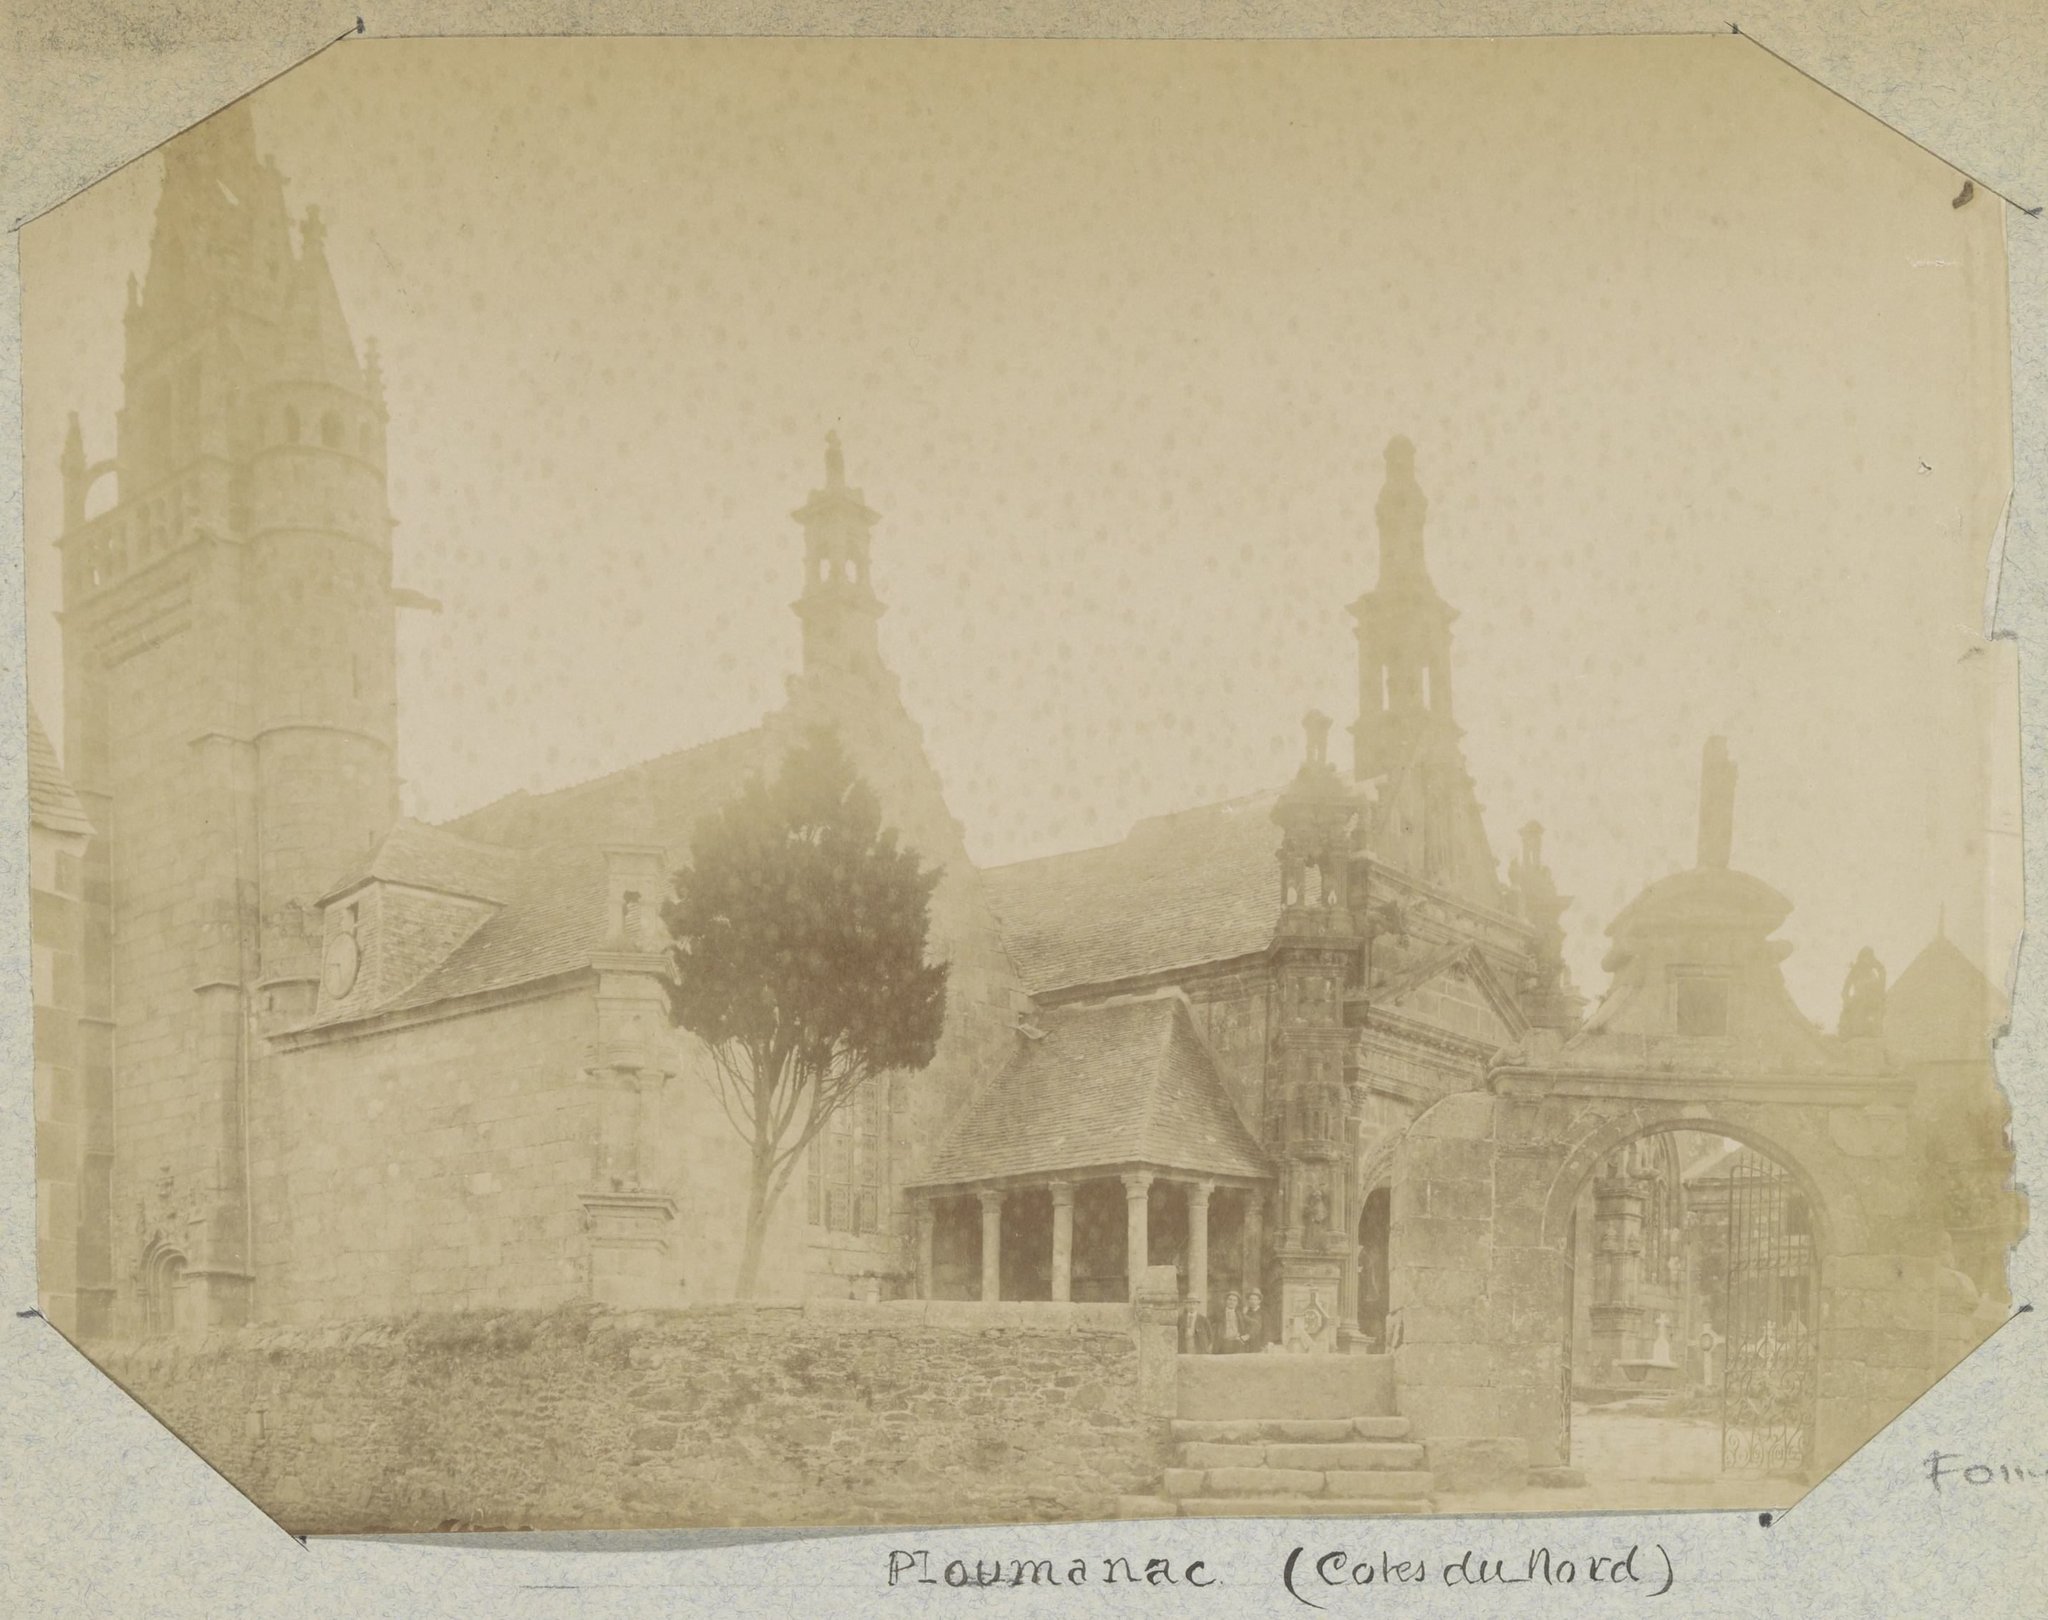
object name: album leaf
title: Kerk met kerkhof (enclos paroissial) te Guimiliau in Bretagne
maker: Anonymous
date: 1880-1900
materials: paper, photographic support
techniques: albumen print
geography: guimiliau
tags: church (exterior), churchyard, cemetery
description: Onderdeel van Album van een Franse amateur met foto's van Frankrijk, Algerije, Palmyra, de Wereldtentoonstelling van 1900 en van bekende Fransen.